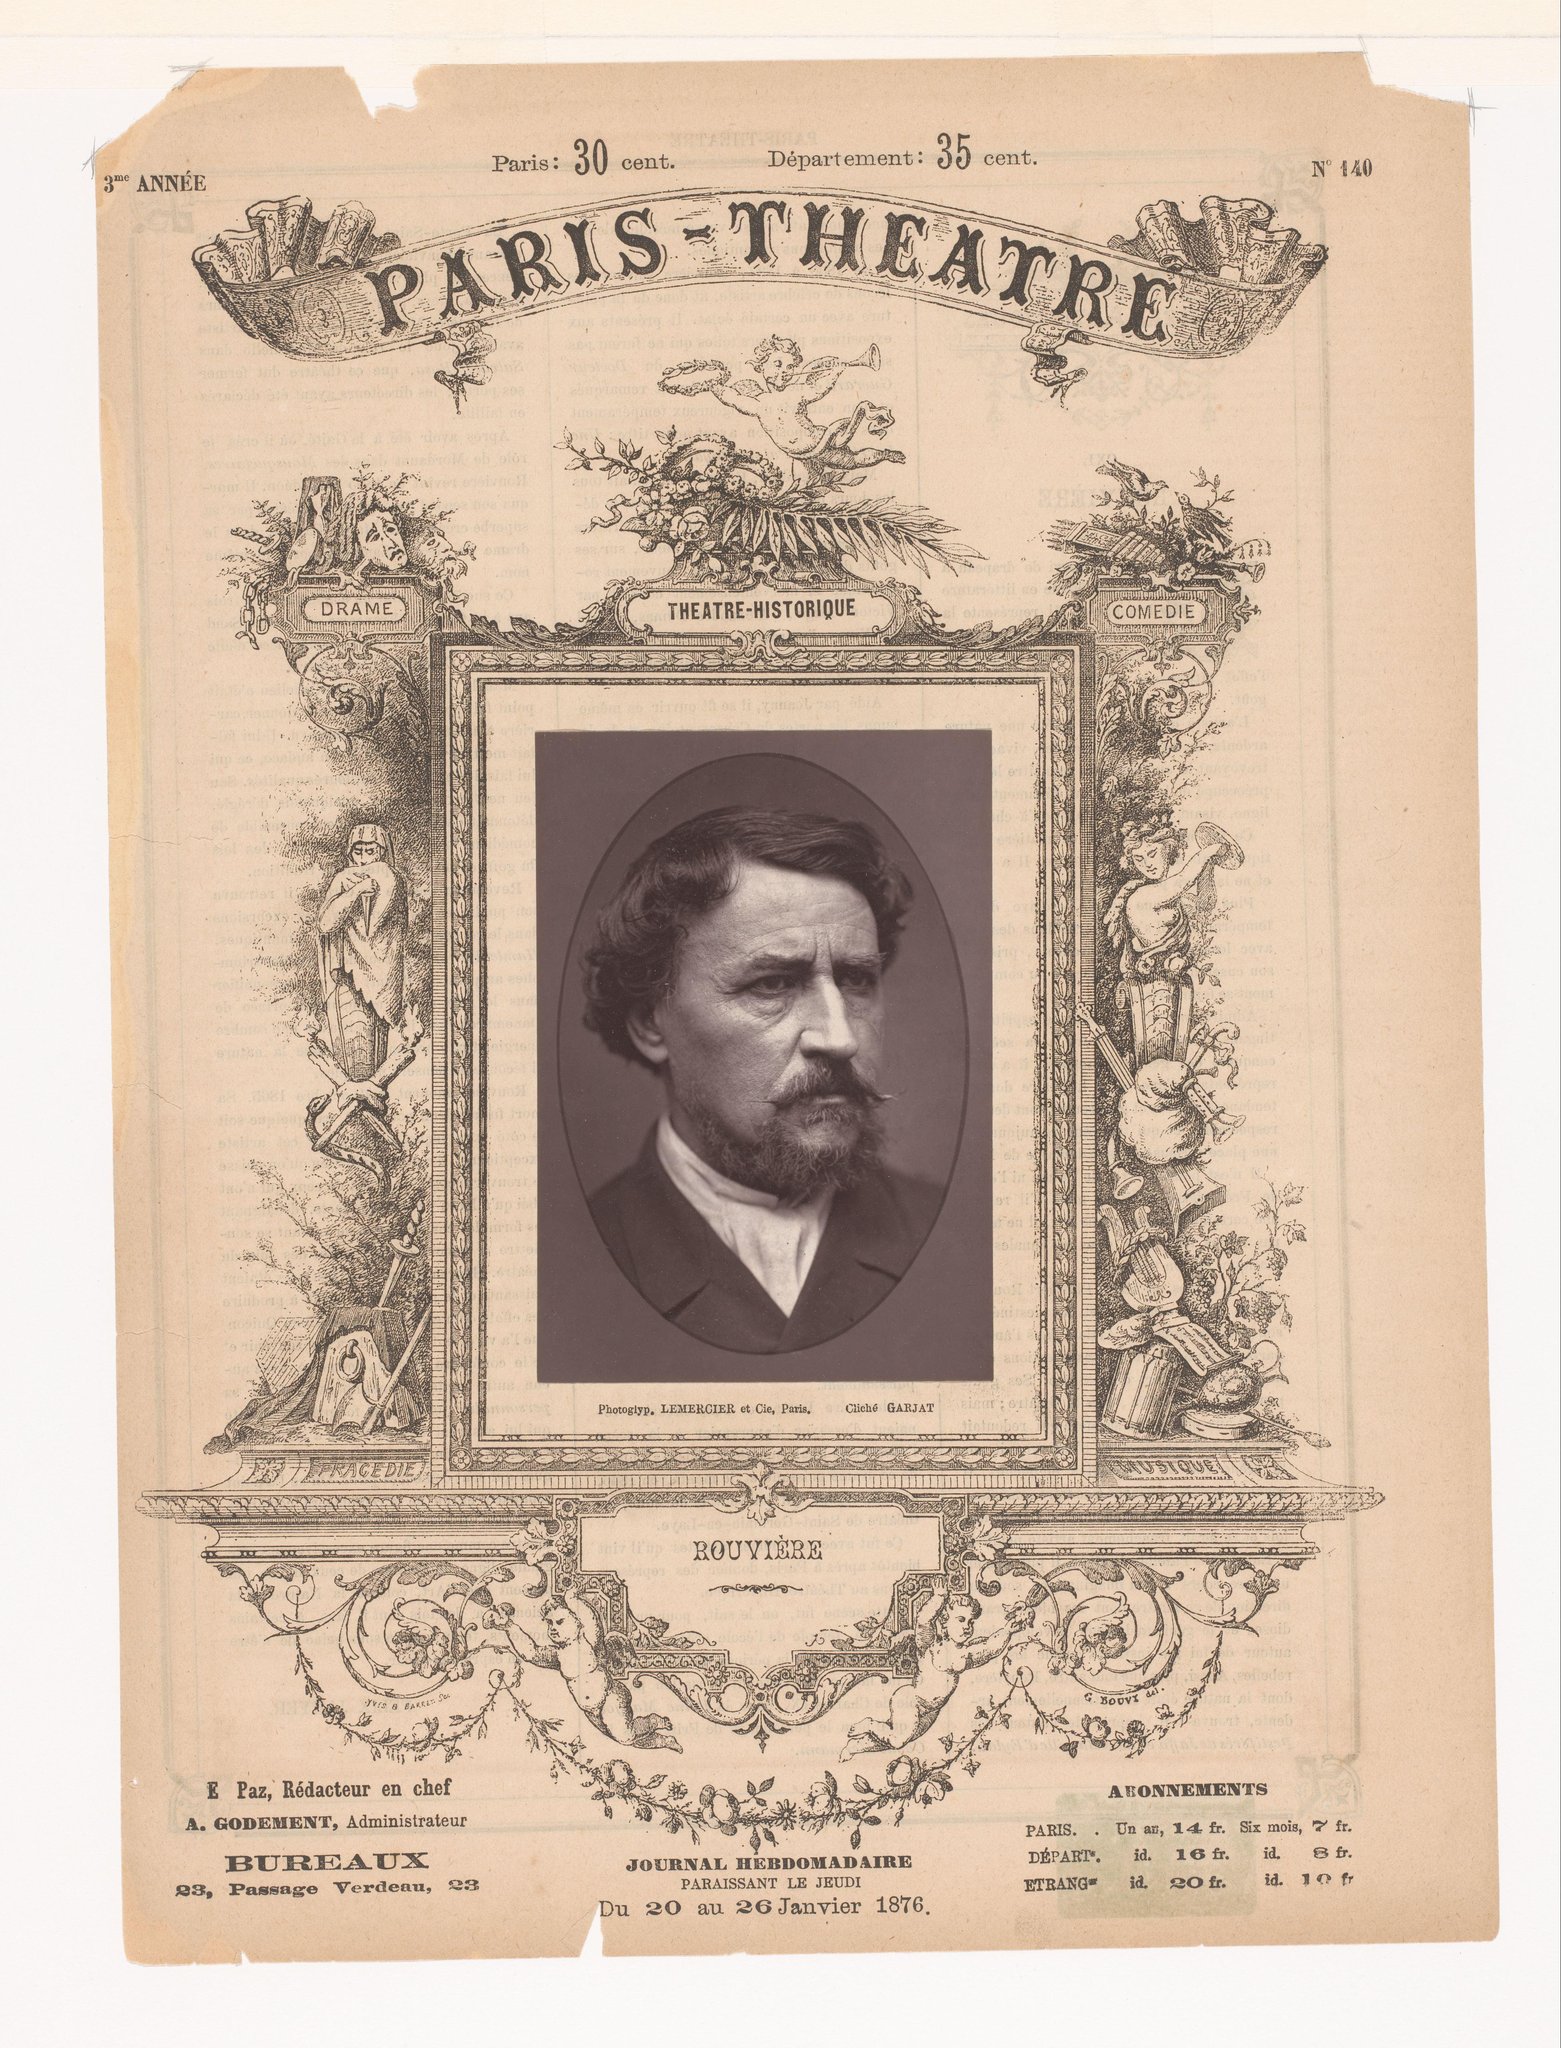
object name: photograph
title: Portret van Philibert Rouvière (1809-1865), Frans acteur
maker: étienne carjat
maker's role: draughtsman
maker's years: 1828-1906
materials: paper, photographic support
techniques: woodburytype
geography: paris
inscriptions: inscription: ‘Photoglyp. LEMERCIER et Cie, Paris.’, inscription: ‘ROUVIÈRE’, inscription: ‘PARIS-THÉATRE’, inscription: ‘Cliché Garjat’, inscription: ‘SIXIÈME ANNÉE - NUMÉRO 281//E.PAZ, Rédacteur en chef//A. GODEMENT, Administrateur//BUREAUX//23, Passage Vordeau, 23//Journal Hebdomadaire paraissant le Jeudi//Du 20 au 26 janvier 1876//PARIS: 30 cent - Départ: 35 cent.//Abonnement: [etc]’